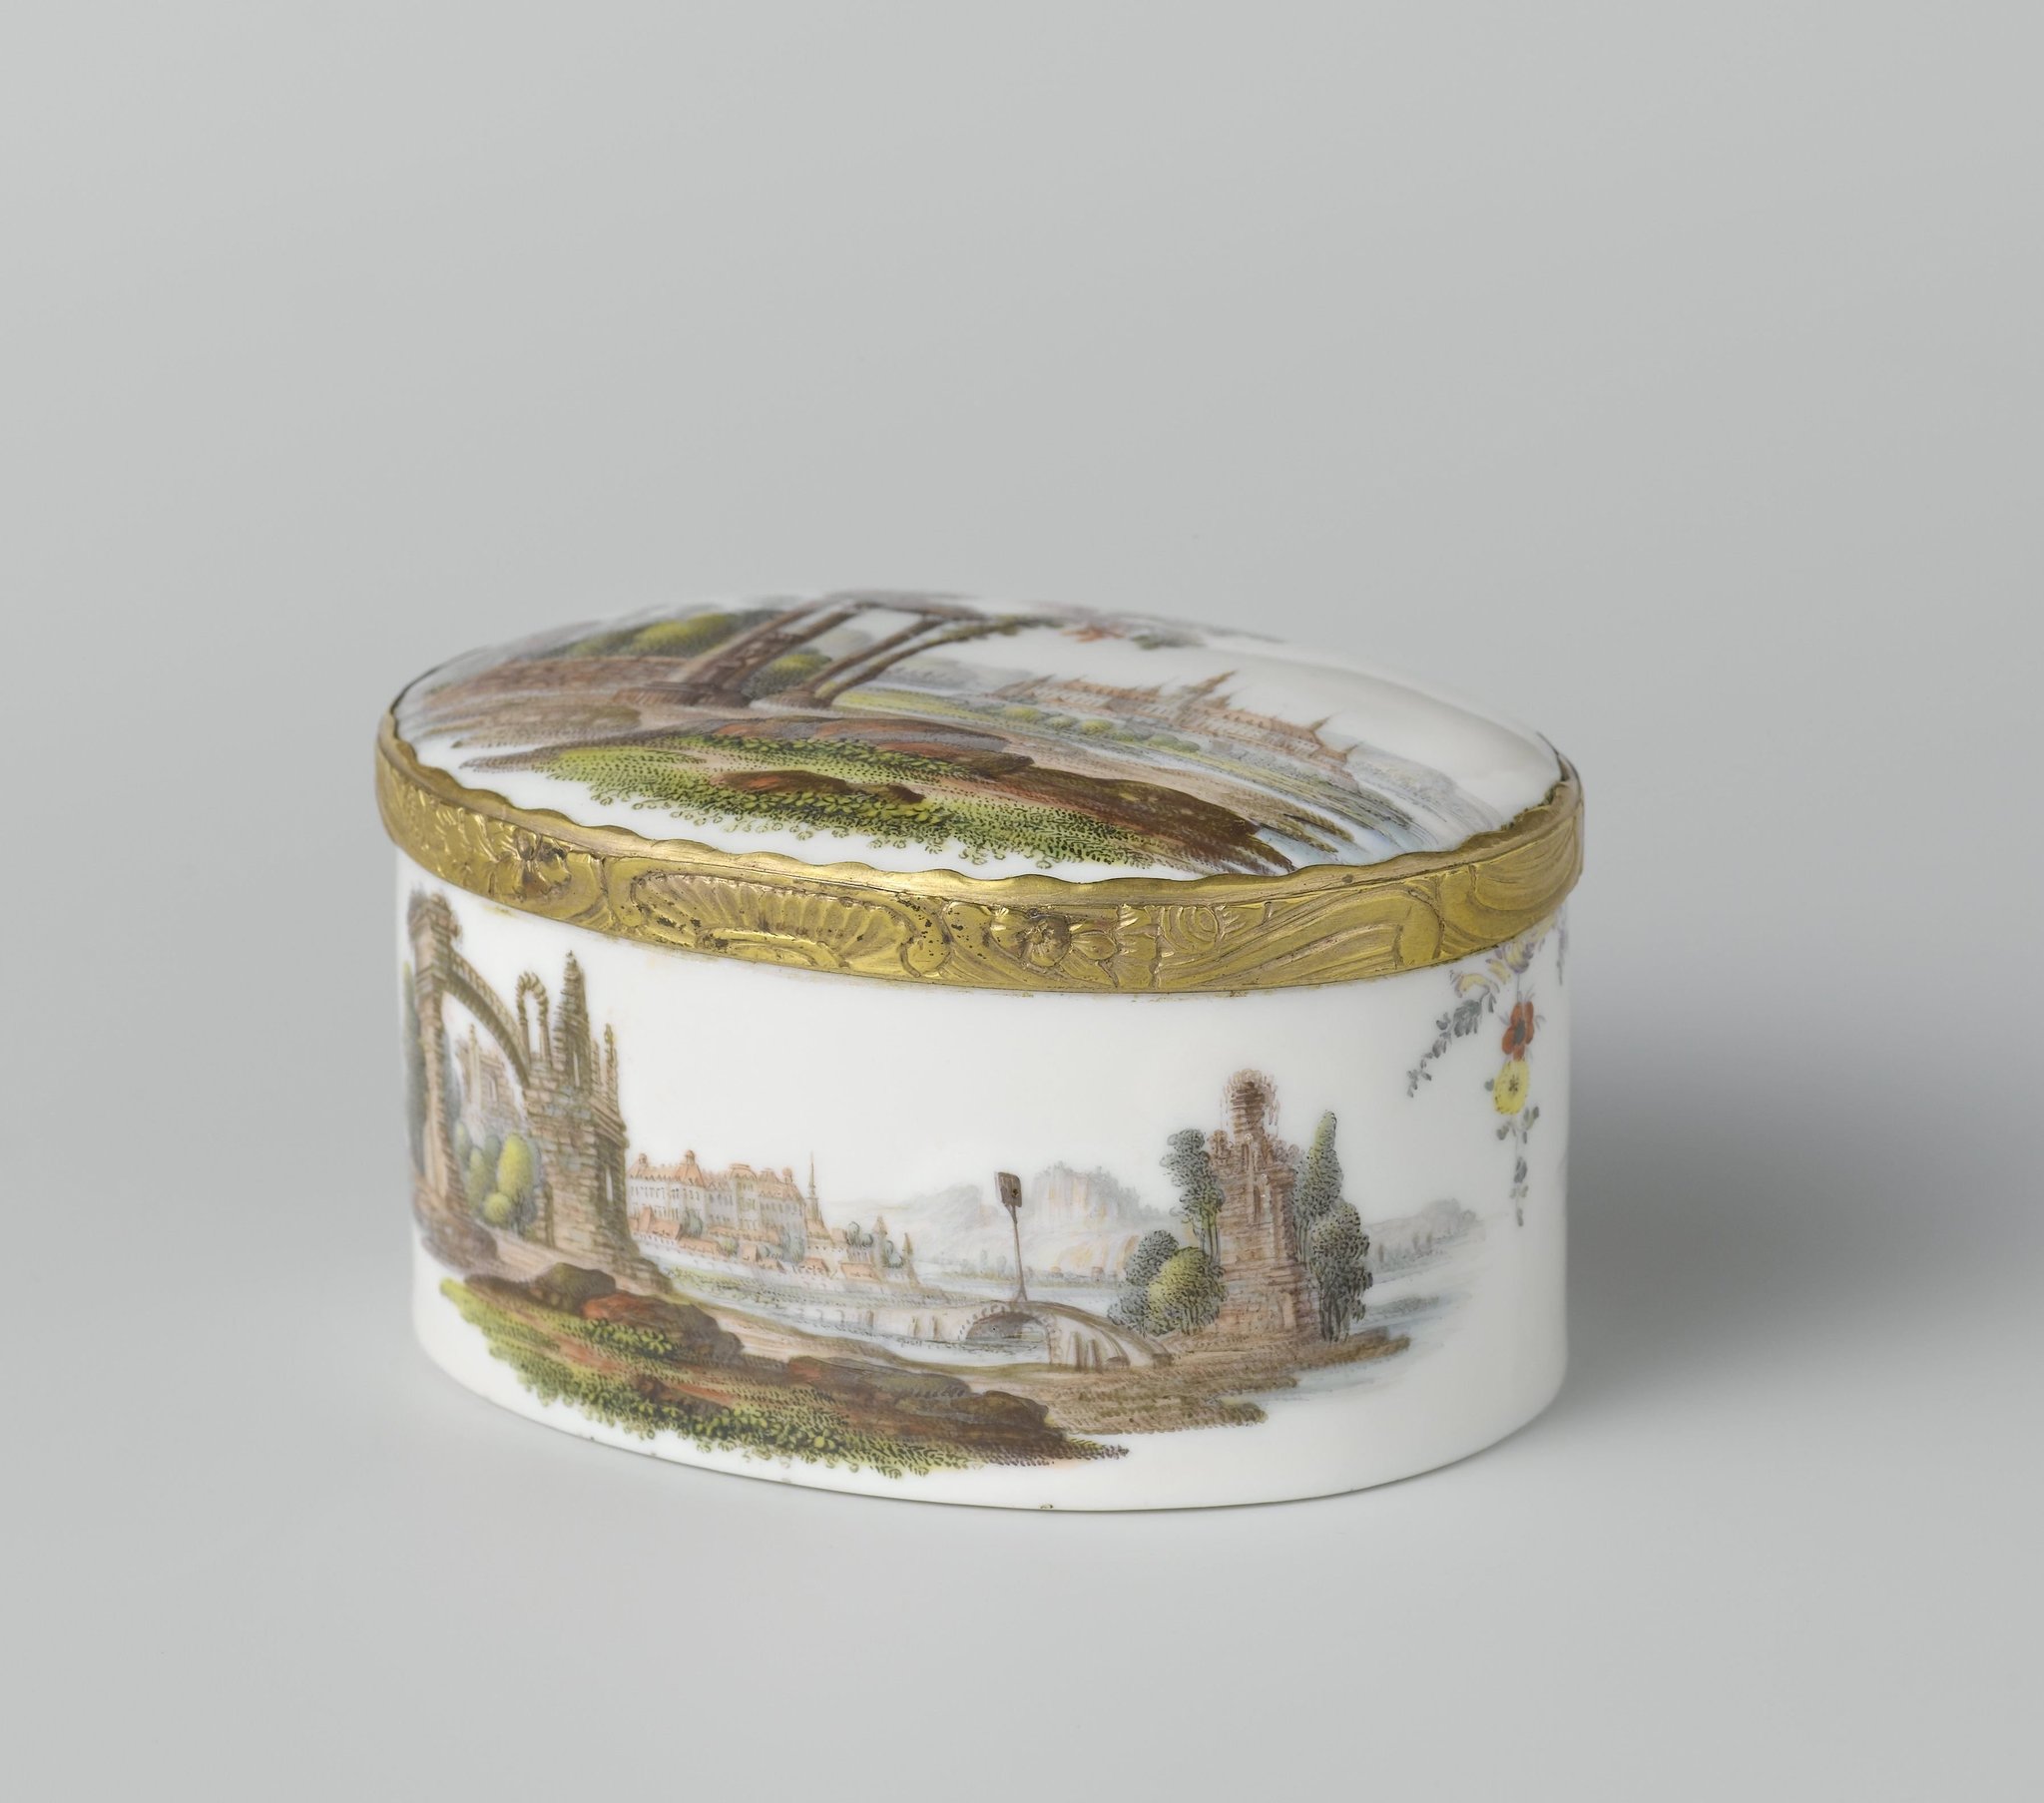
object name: snuffbox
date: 1760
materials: copper, porcelain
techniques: gilding, painted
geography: meissen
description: Meissener Porzellan Manufaktur Meissen, c. 1760 hard-paste porcelain, gilt copper